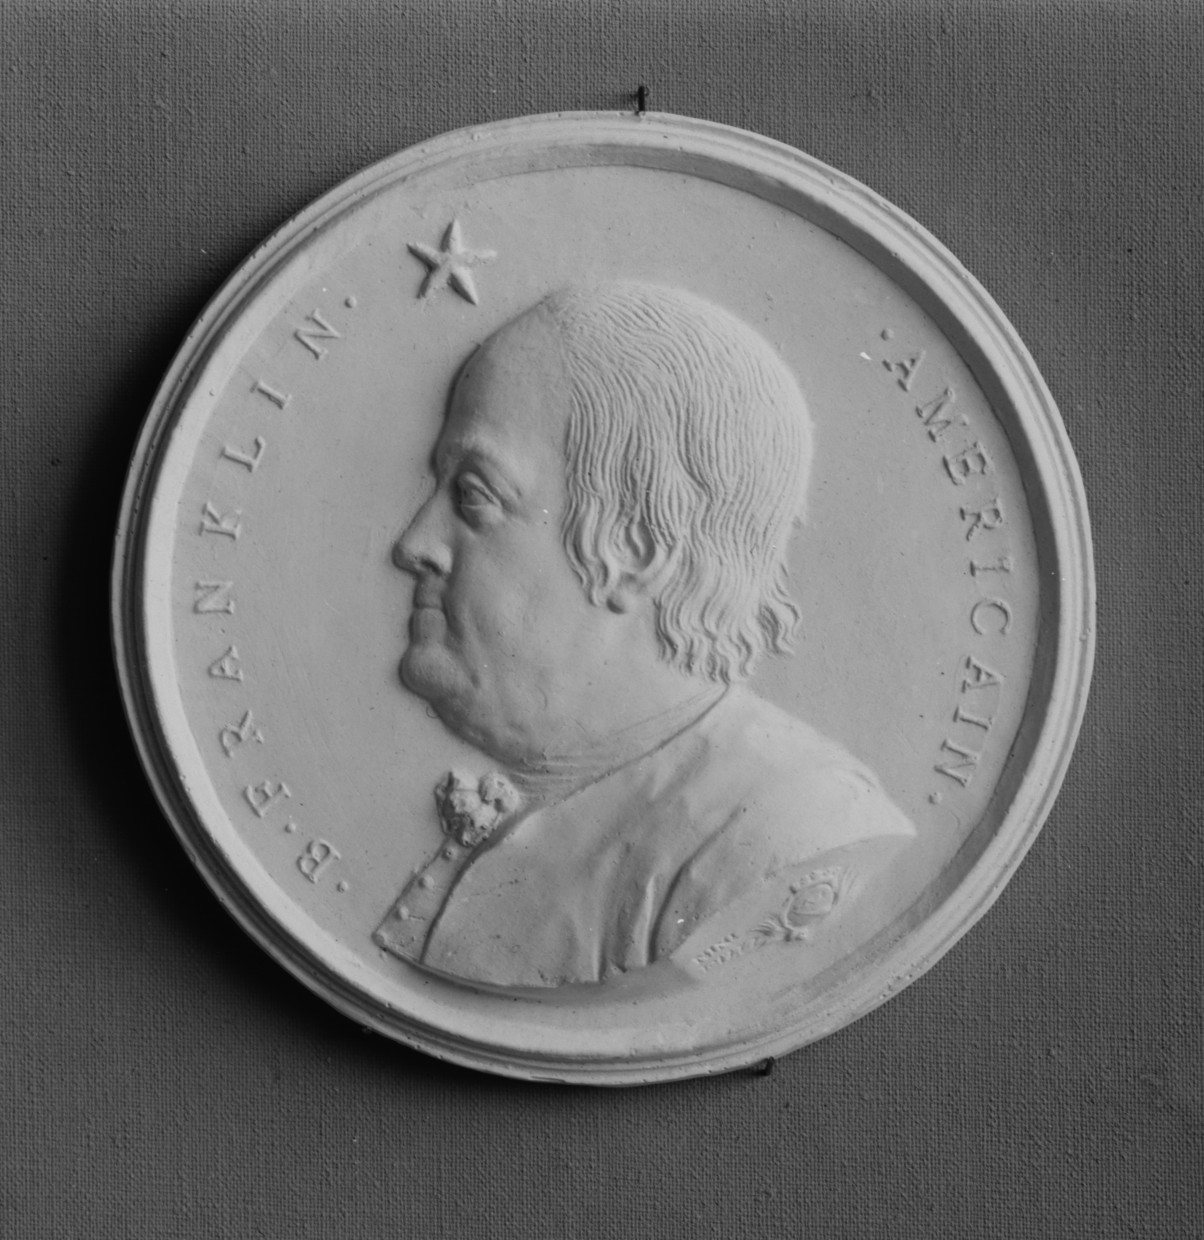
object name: medallion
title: Benjamin Franklin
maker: jean-baptiste nini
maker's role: artist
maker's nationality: italian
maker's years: 1717-1786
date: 1701-1800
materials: plaster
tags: benjamin franklin,profiles